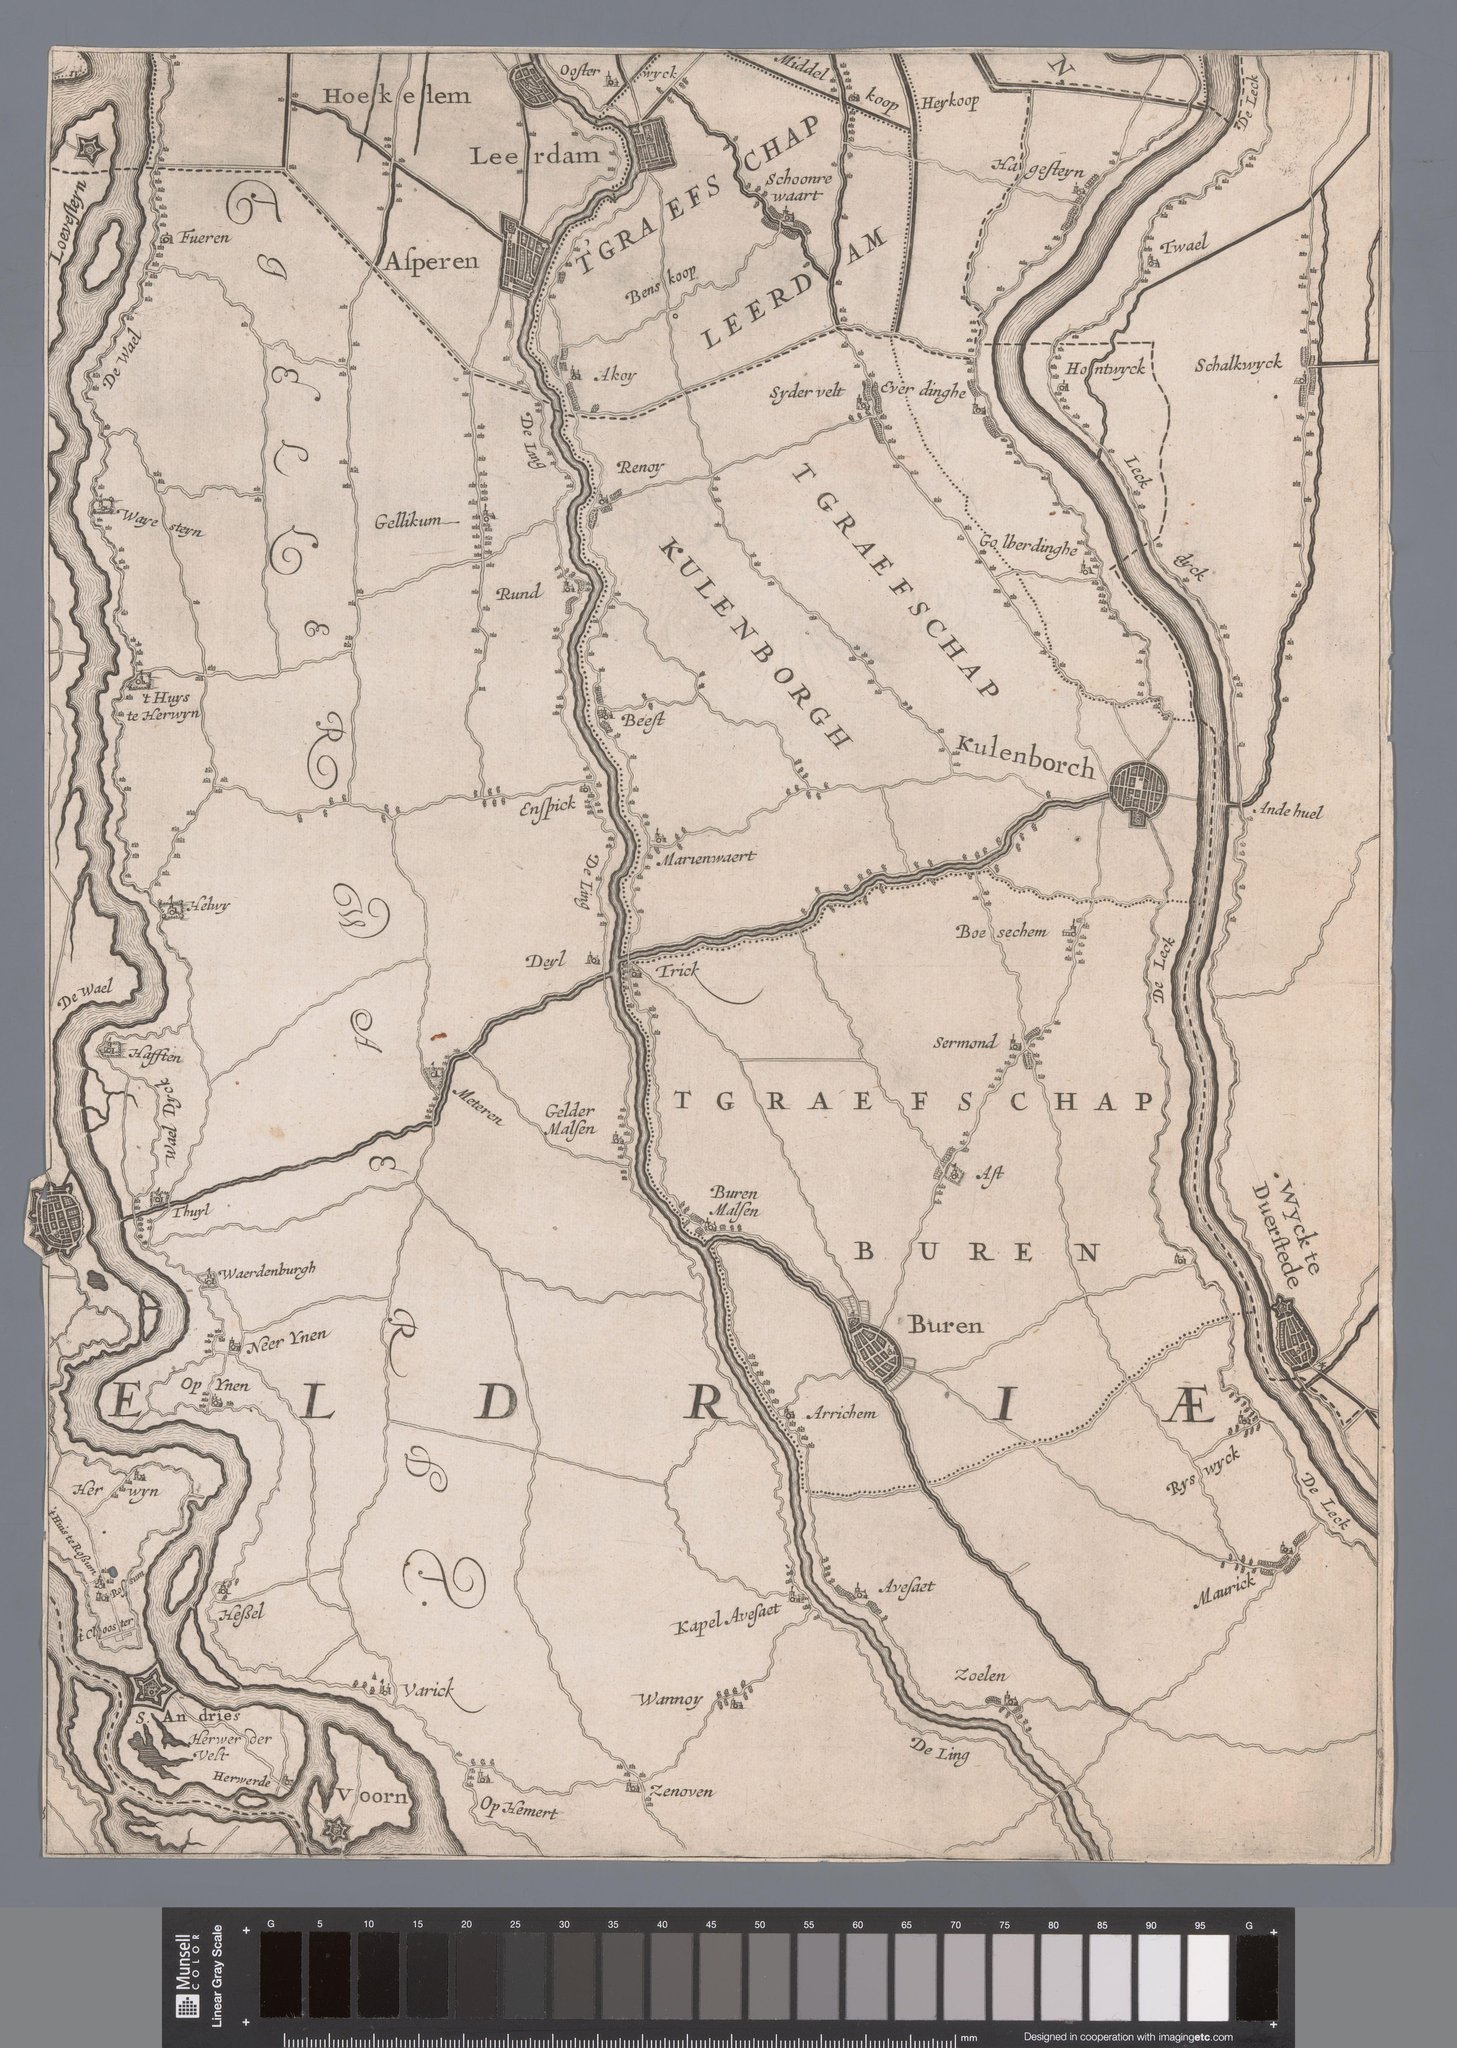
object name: print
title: Kaart van het Graafschap Holland en Utrecht (plaat 33)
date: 1639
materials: paper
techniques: engraving, etching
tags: maps, atlases, wijk bij duurstede, buren, asperen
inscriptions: collector's mark: Lugt 2228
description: Onderdeel van een kaart samengesteld uit 40 bladen. Waarschijnlijk gaat het om de grootste kaart van Holland uit de zeventiende-eeuw. De kaart is uitgegeven in verschillende edities, deze kaart uit 1639 is de eerste editie.